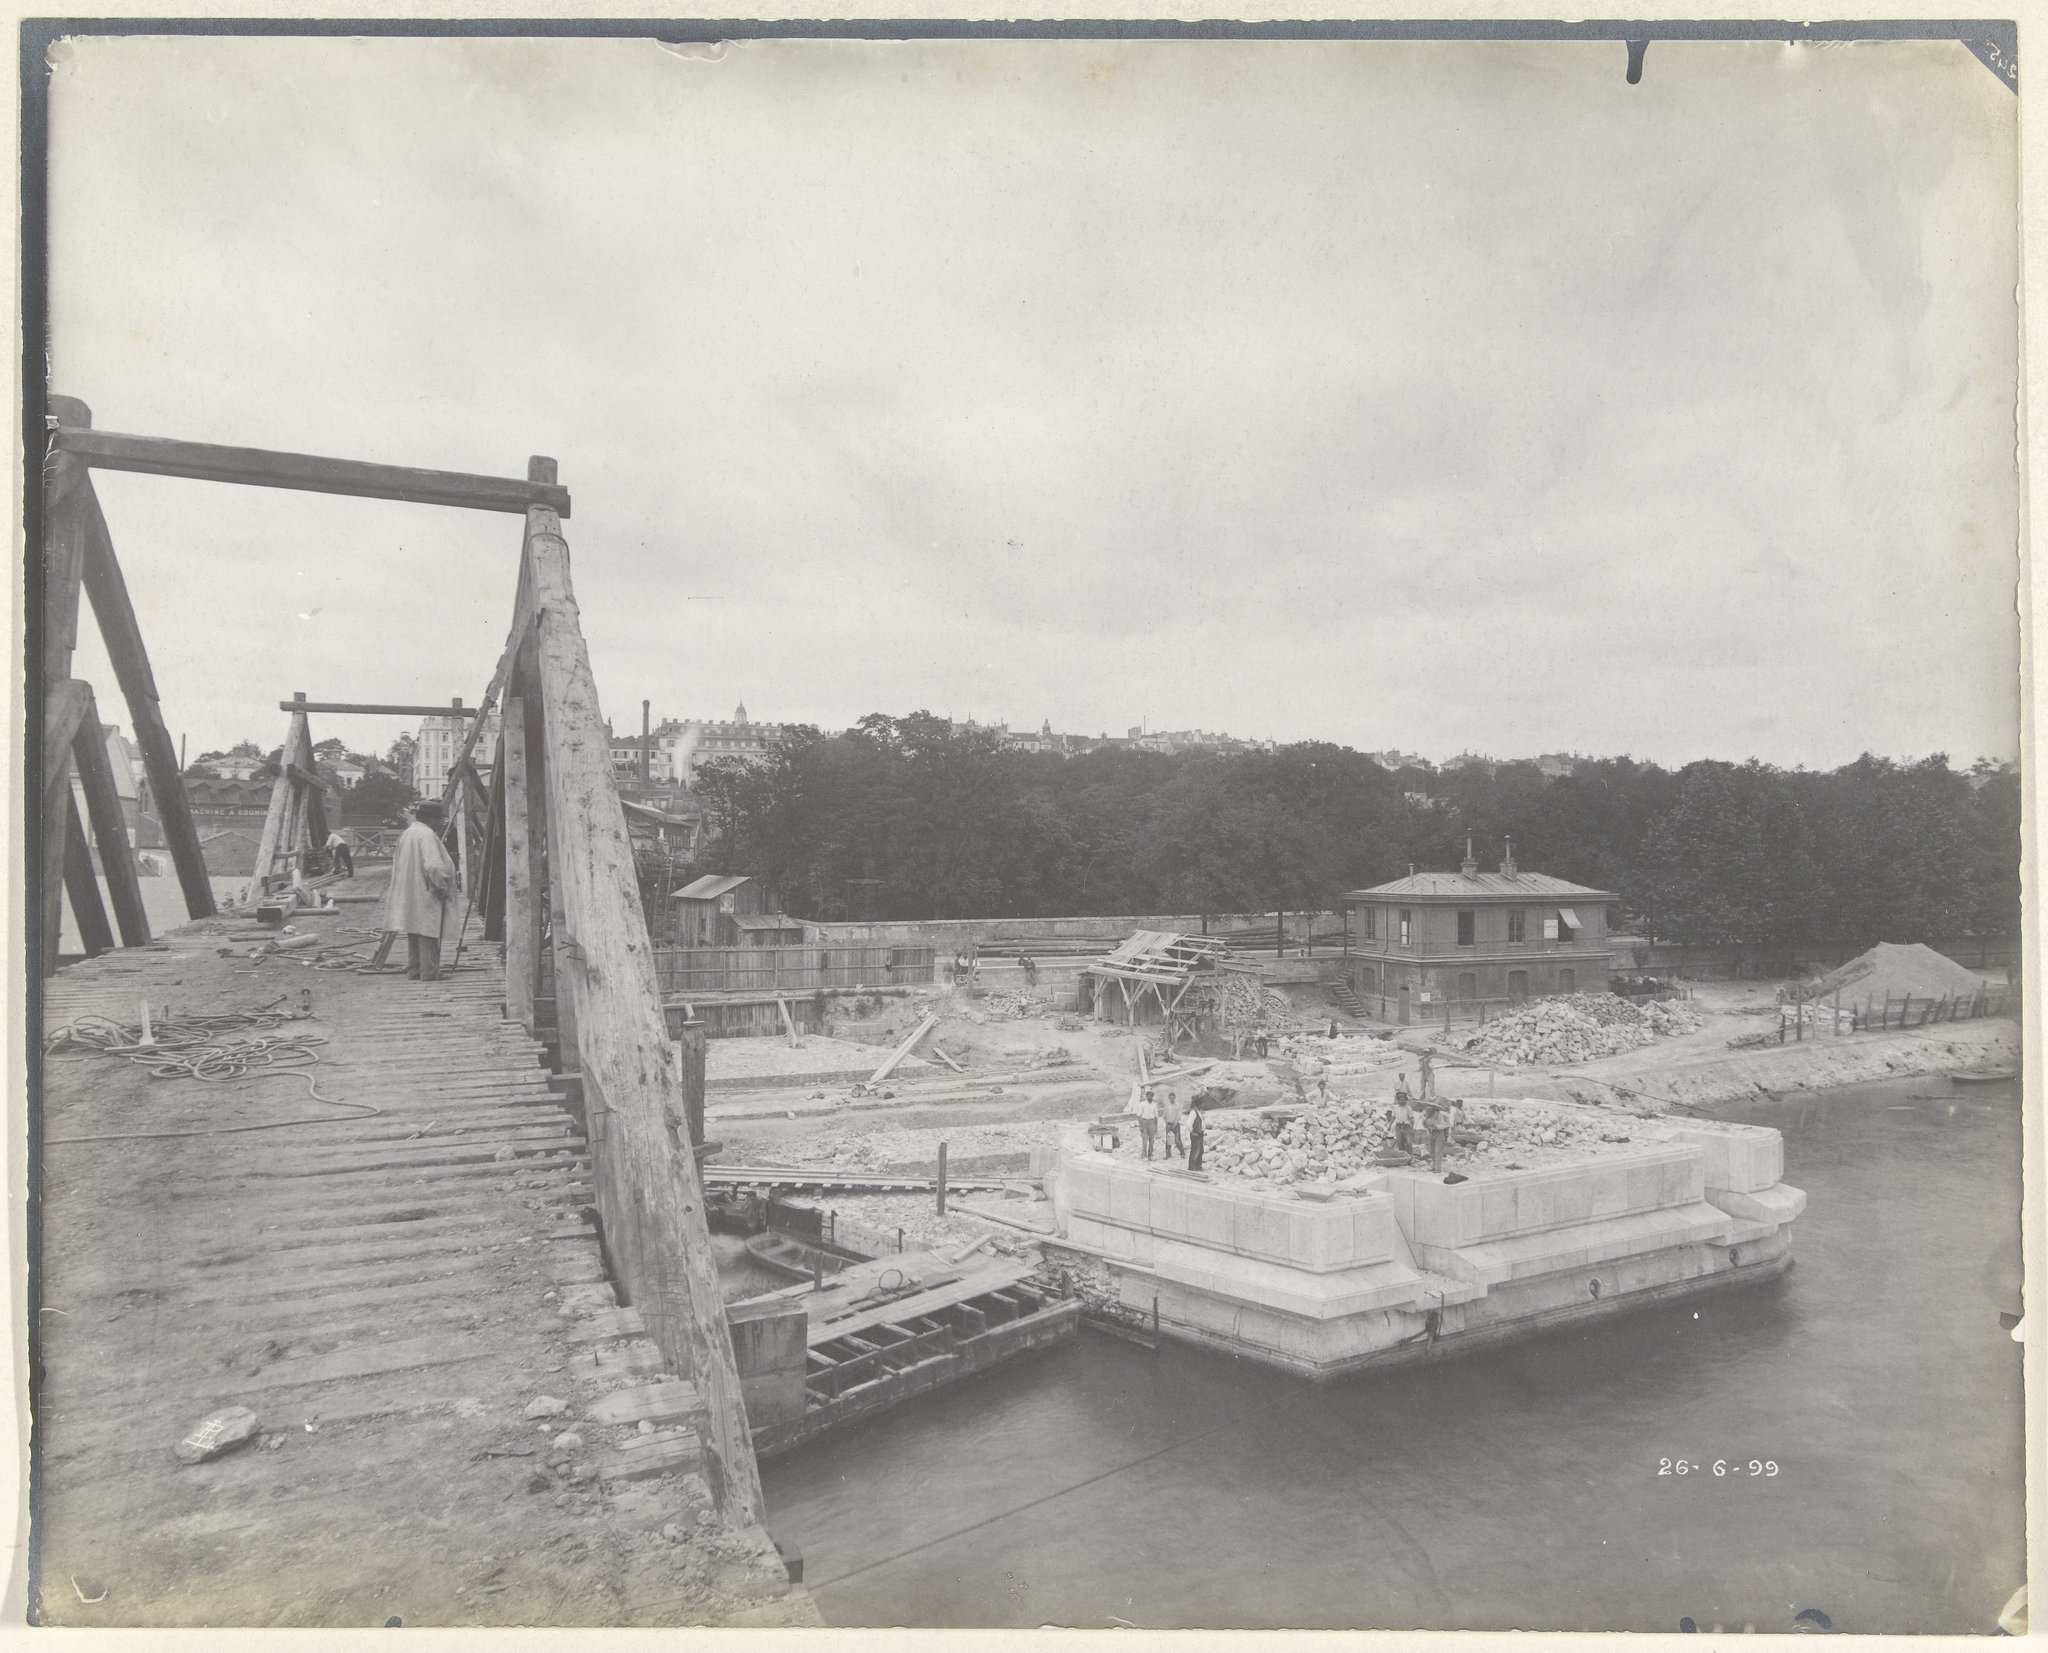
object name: photograph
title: Construction of the Pont Rouelle in Paris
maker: emmanuel l. pottier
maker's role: fotograaf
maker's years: 1864-1921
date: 1899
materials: paper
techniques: gelatin silver print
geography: paris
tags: building-site, bridge in city across river, canal, etc., paris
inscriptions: number: ‘249’, date: ‘26-6-99’, monogram: ‘L.P.’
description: To better accommodate the millions of visitors to the 1900 Exposition Universelle in Paris, the Pont Rouelle was built over the Seine River. This bridge was an essential link connecting two Paris train stations. As for every building project a photographer was present to document the progress. The photographer wrote his initials, ELP, on a stone (in the negative).